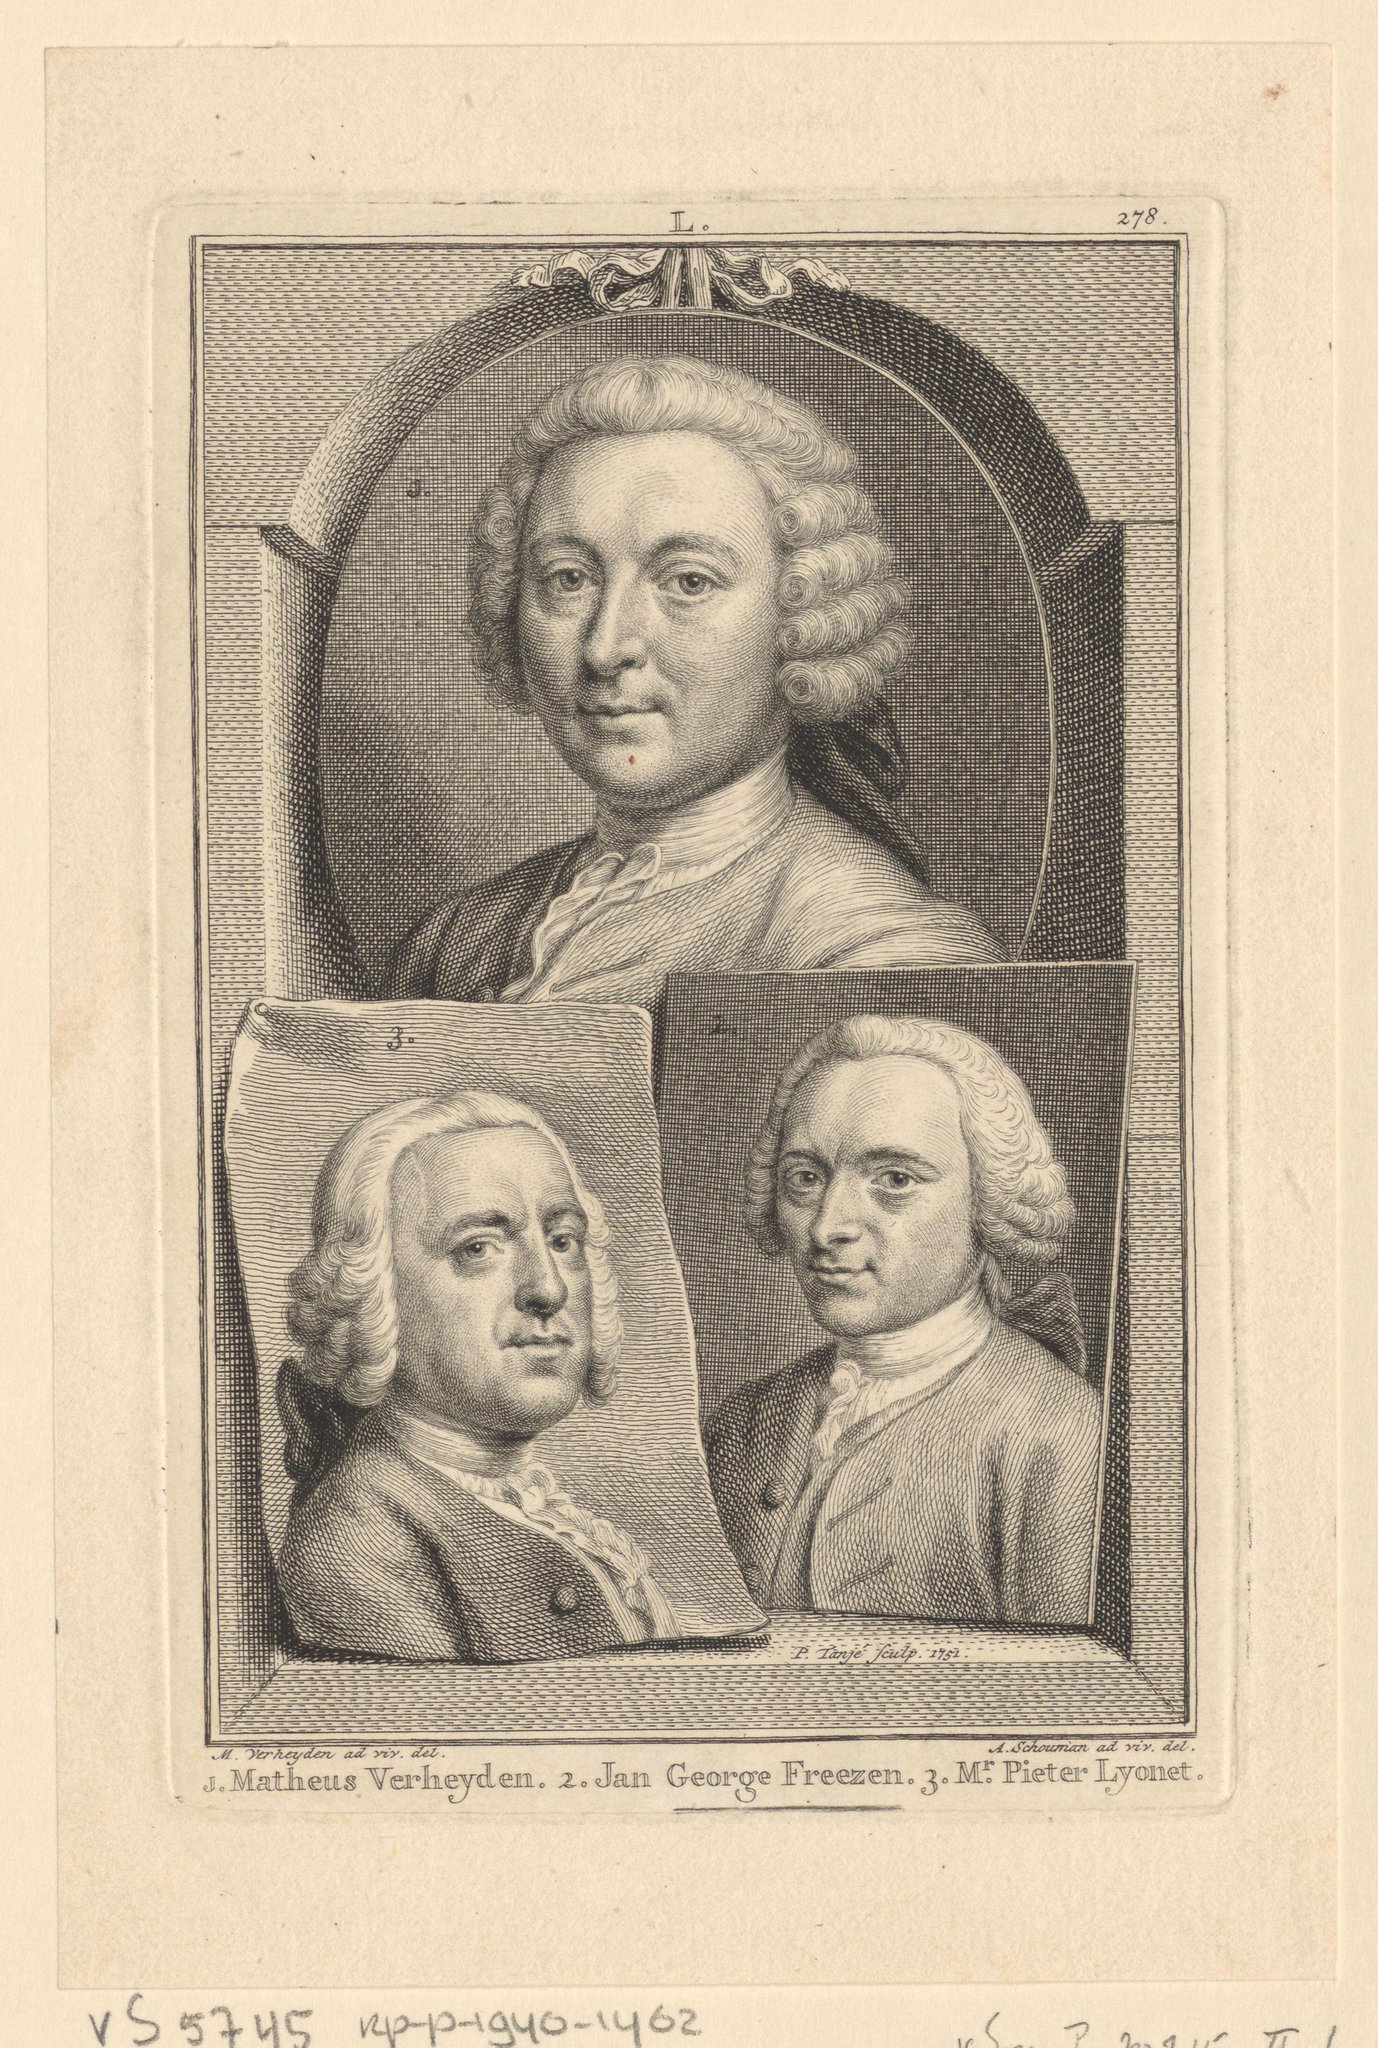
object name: print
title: Portretten van Mattheus Verheijden, Jan George Freezen en Pieter Lyonet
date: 1751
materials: paper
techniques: engraving, etching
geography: northern netherlands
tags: print maker, pieter lyonet, the hague, painter, draughtsman, mattheus verheyden, historical persons, portrait, self-portrait of painter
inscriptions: collector's mark: Lugt 2760, collector's mark: Lugt 2228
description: Prent waarschijnlijk uit: Gool, Johan van. De nieuwe Schouburg der Nederlantsche kunstschilders en schilderessen (...). Den Haag: 1751, dl. 2, p. 278.